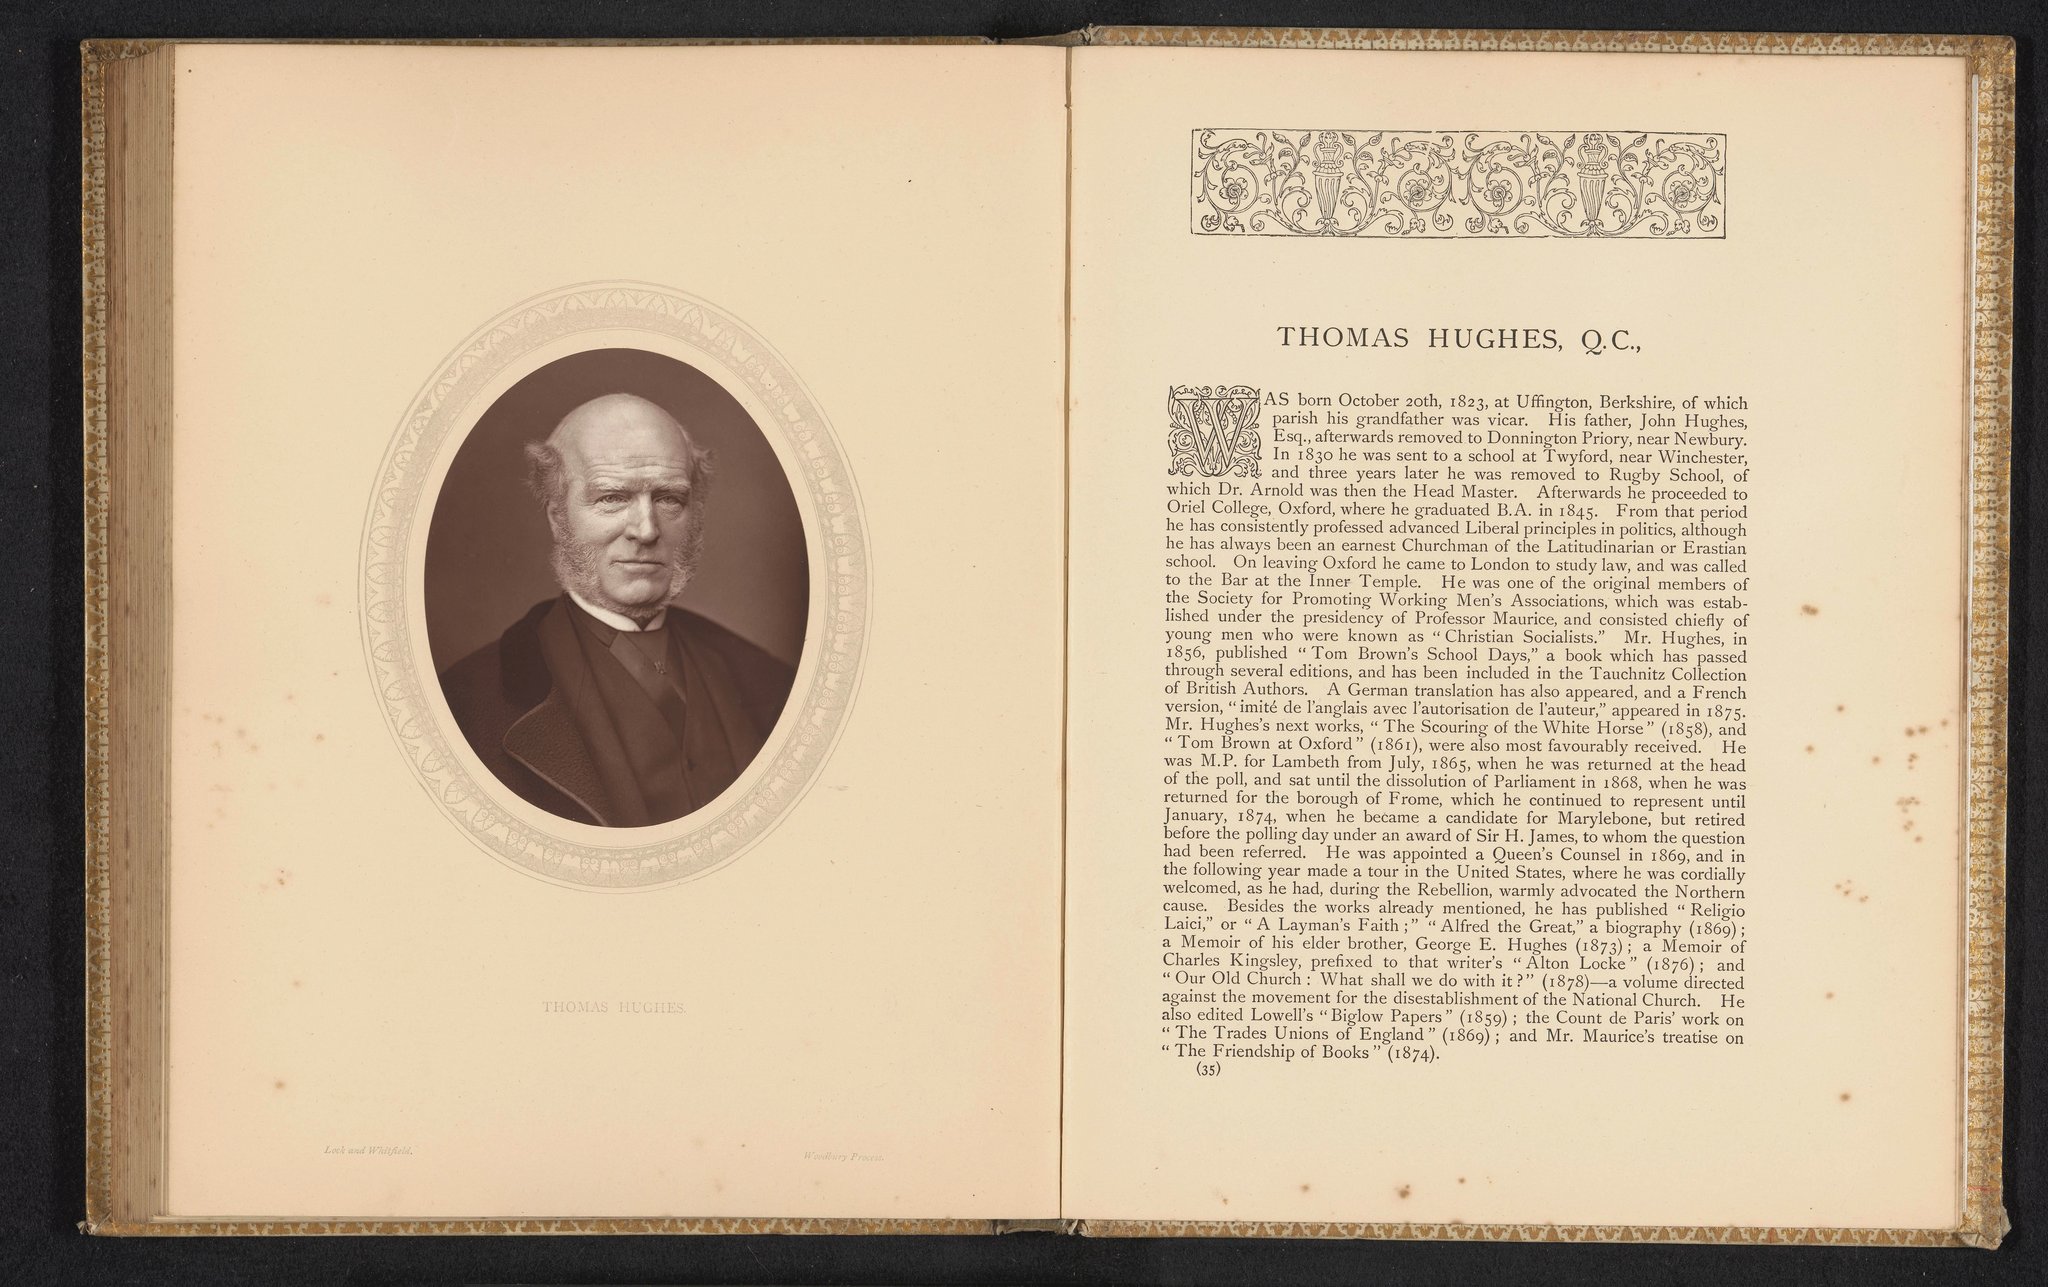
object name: page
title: Thomas Hughes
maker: Anonymous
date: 1875-1880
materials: paper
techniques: woodburytype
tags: lawyer, attorney at law, historical persons (portraits and scenes from the life) (+ (full) bust portrait)